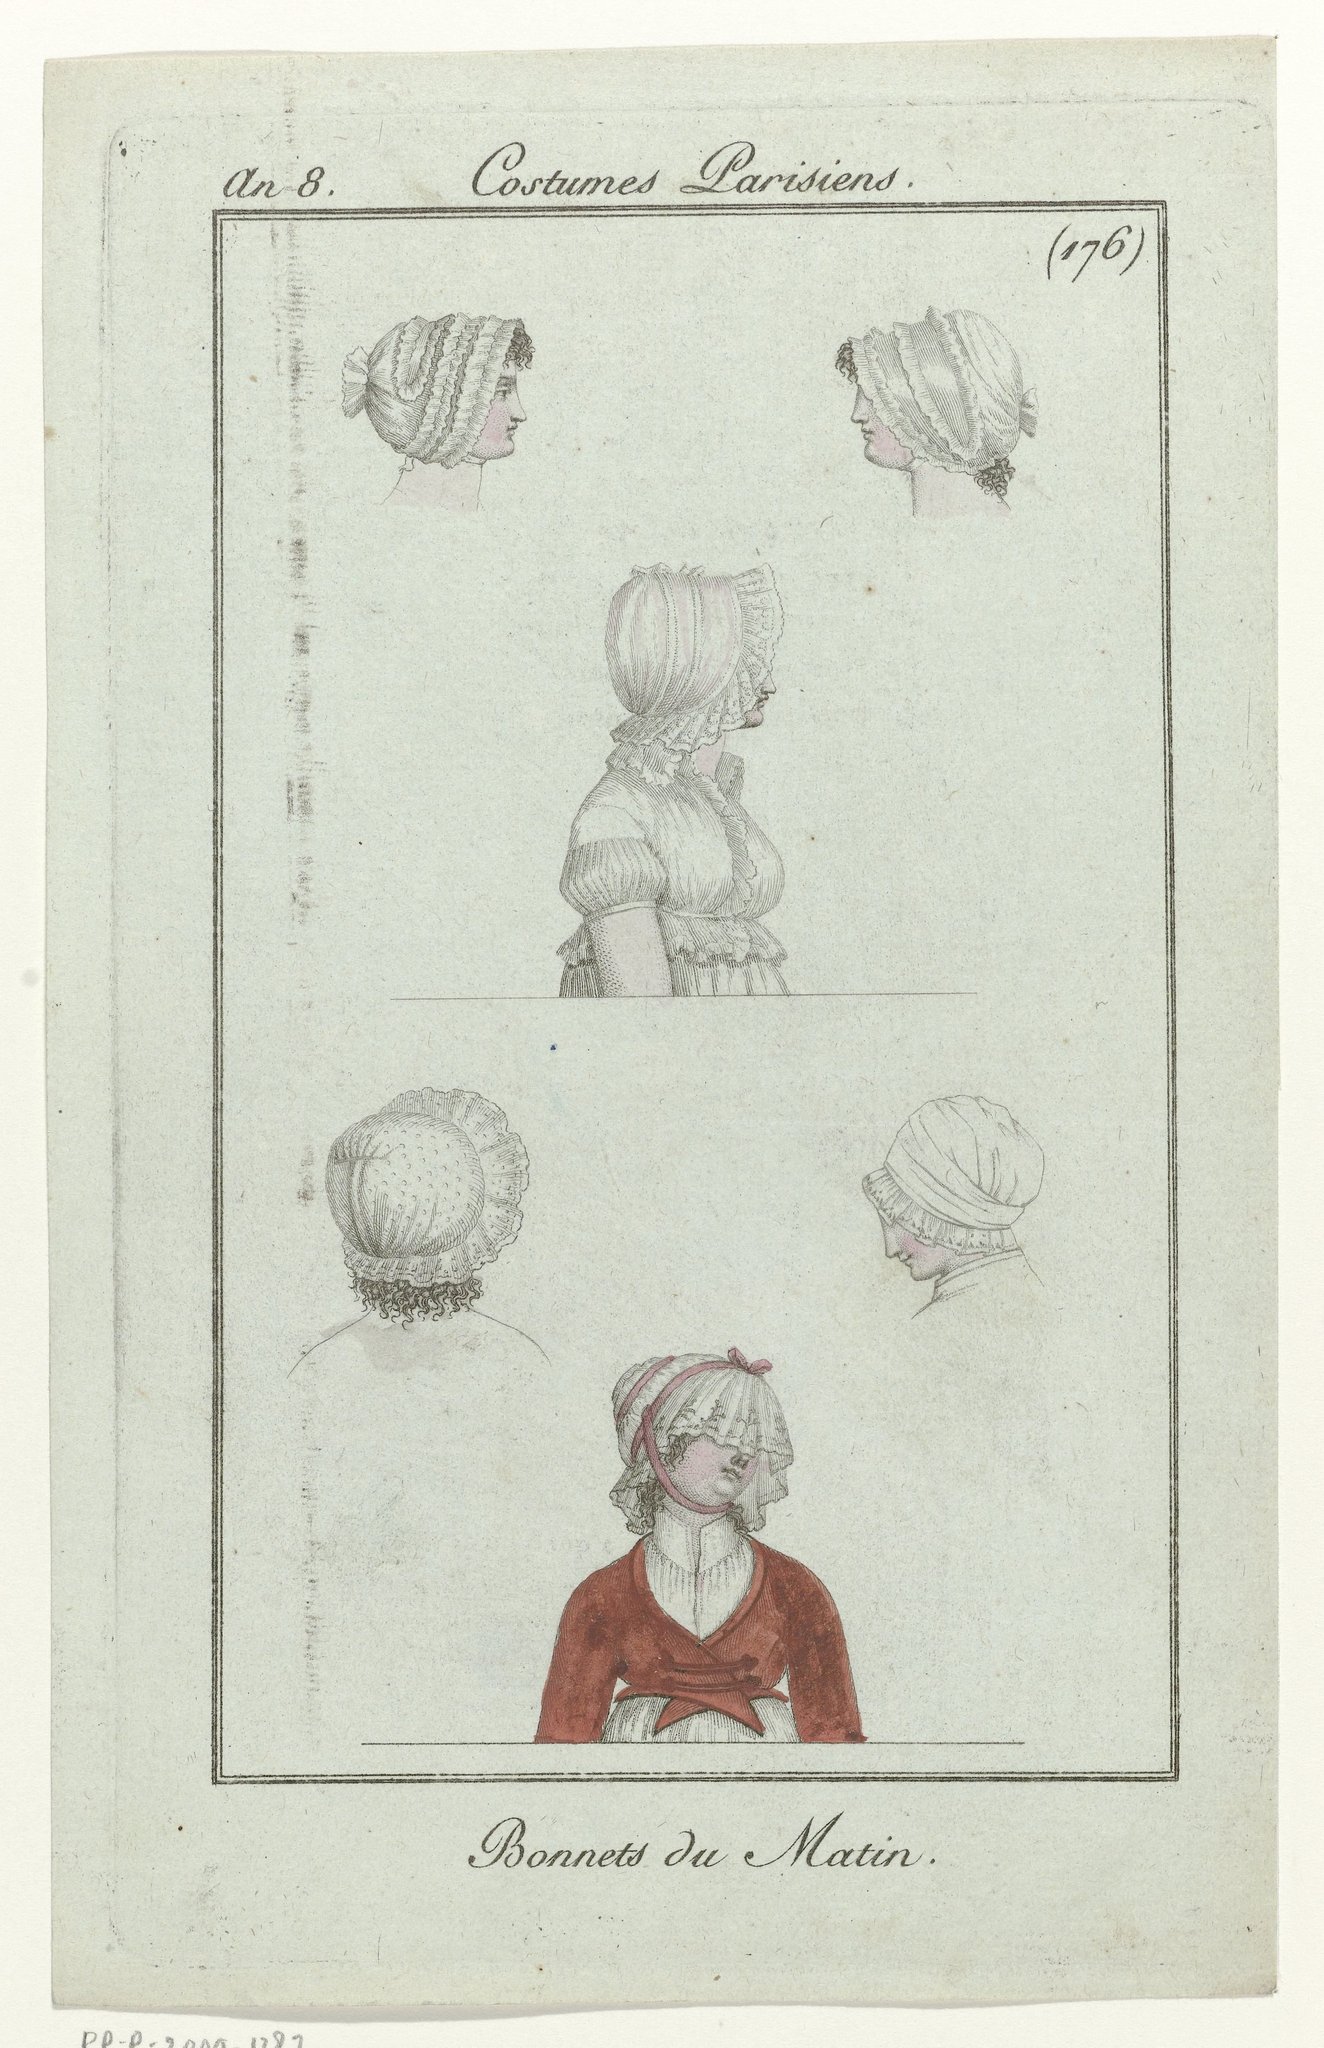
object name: fashion print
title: Journal des Dames et des Modes, Costume Parisien, 6 décembre 1799, An 8 (176) : Bonnets du Matin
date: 1799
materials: paper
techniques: engraving, hand coloring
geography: paris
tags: clothing for the upper part of the body (+ women's clothes), head-gear: morning cap (+ women's clothes), coat (+ women's clothes), fashion plates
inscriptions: caption: ‘Bonnets du Matin’, title: ‘Costume Parisien.’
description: Vier vrouwenhoofden en twee vrouwenbustes met verschillende mutsen voor in de ochtend. De prent maakt deel uit van het modetijdschrift Journal des Dames et des Modes, uitgegeven door Pierre de la Mésangère, Parijs, 1797-1839.